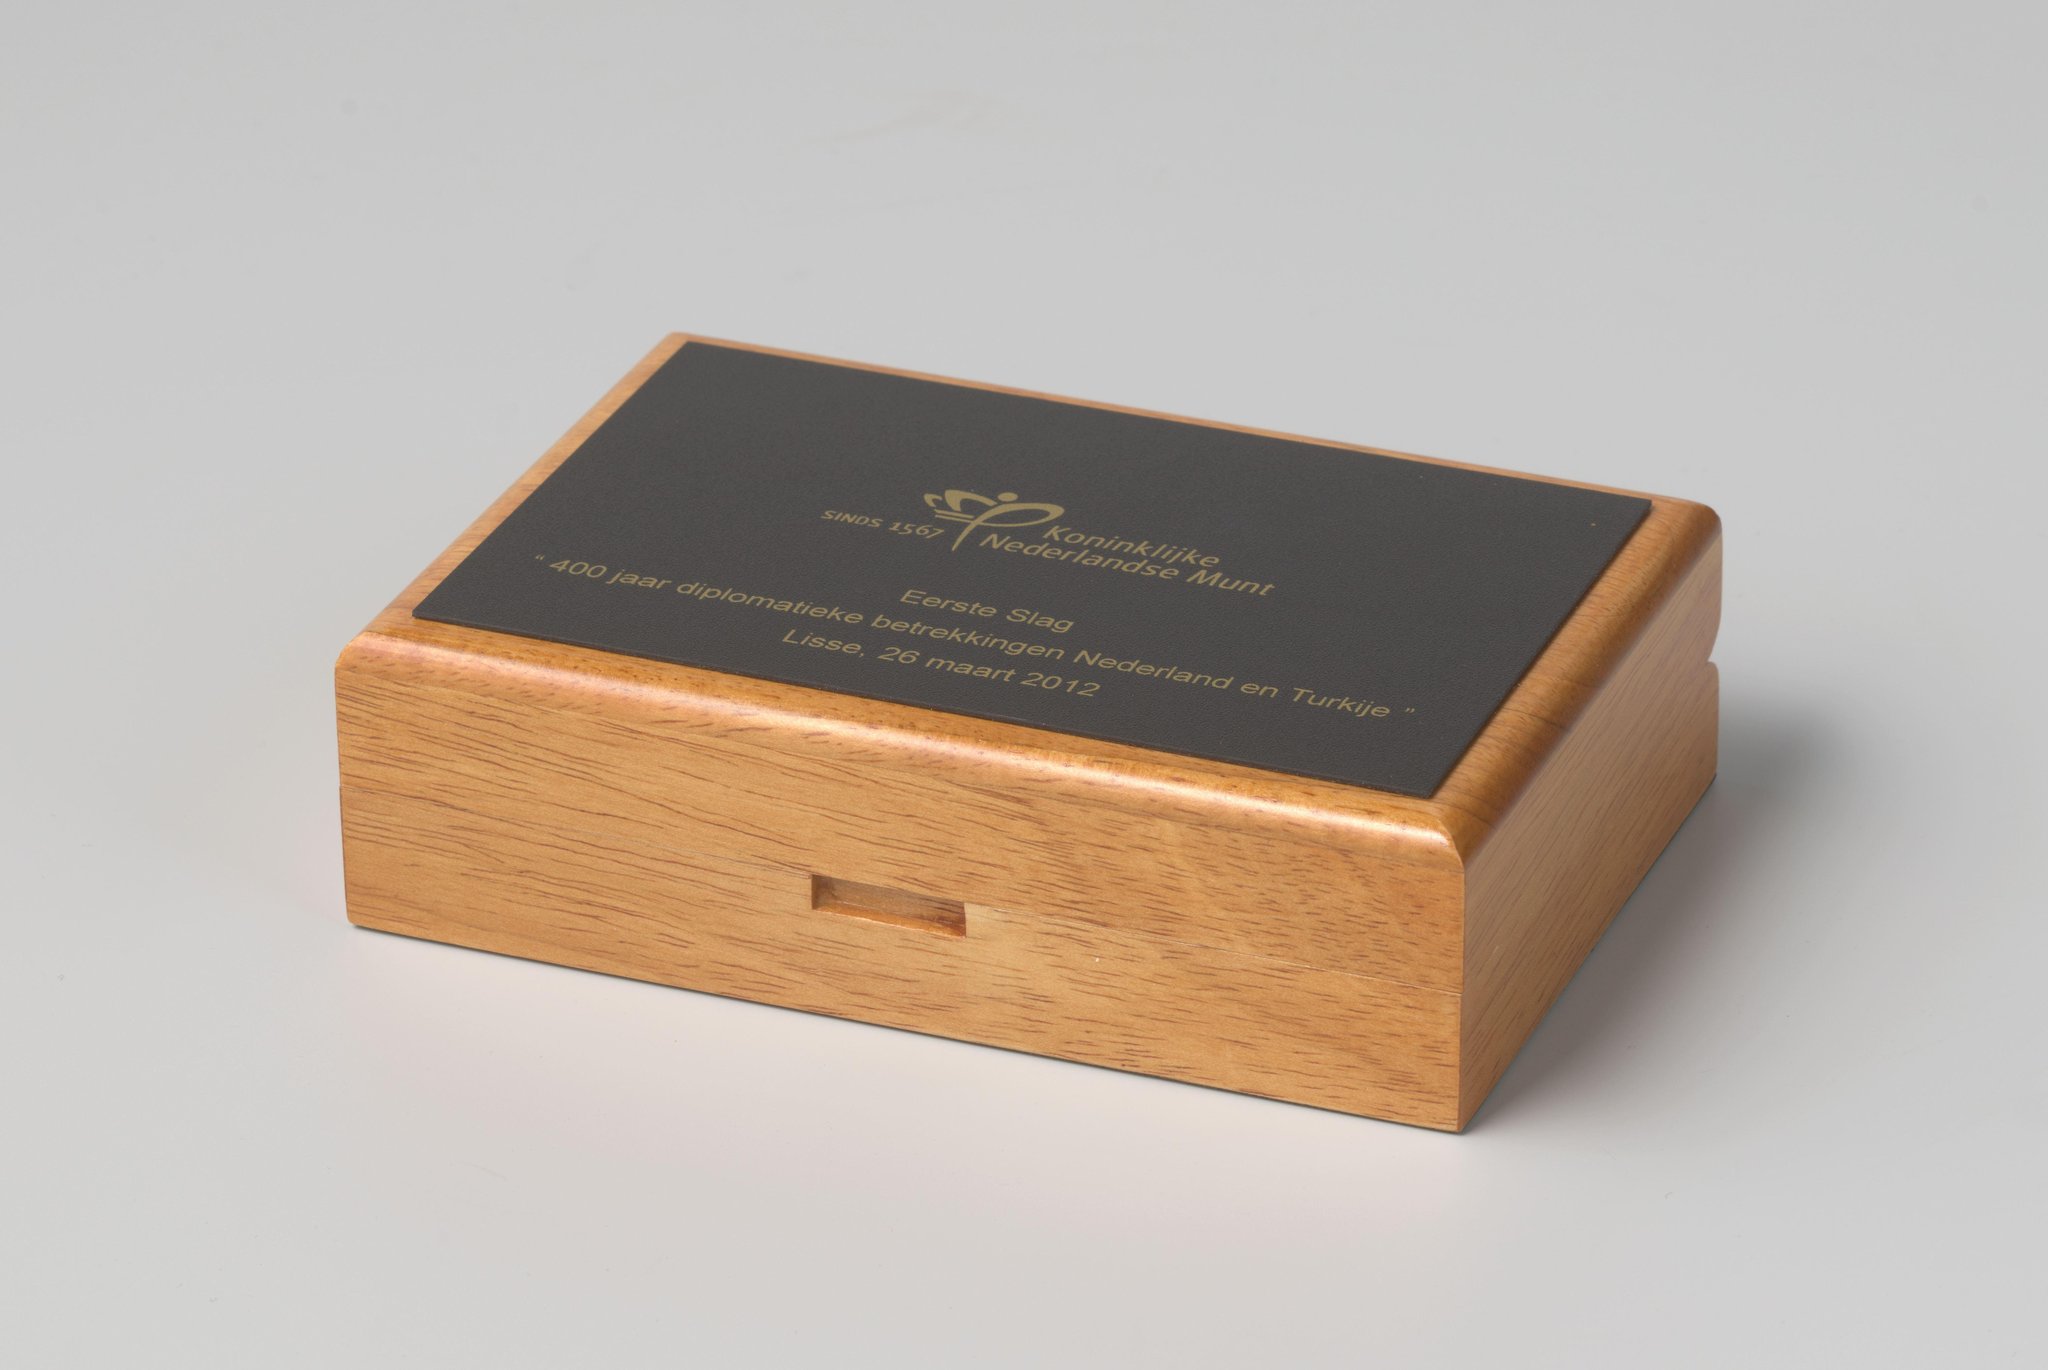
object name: box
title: Doos horend bij het Tulpen Vijfje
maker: deniz seyda tunca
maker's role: vormgever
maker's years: 1973-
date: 2012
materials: velvet, wood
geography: utrecht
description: Houten doos, van binnen met blauw fluweel bekleed, met in deksel aangebracht tekstblad met uitleg; op deksel geplakt leren vel: titel met datering en maker. Horend bij het Tulpen Vijfje.